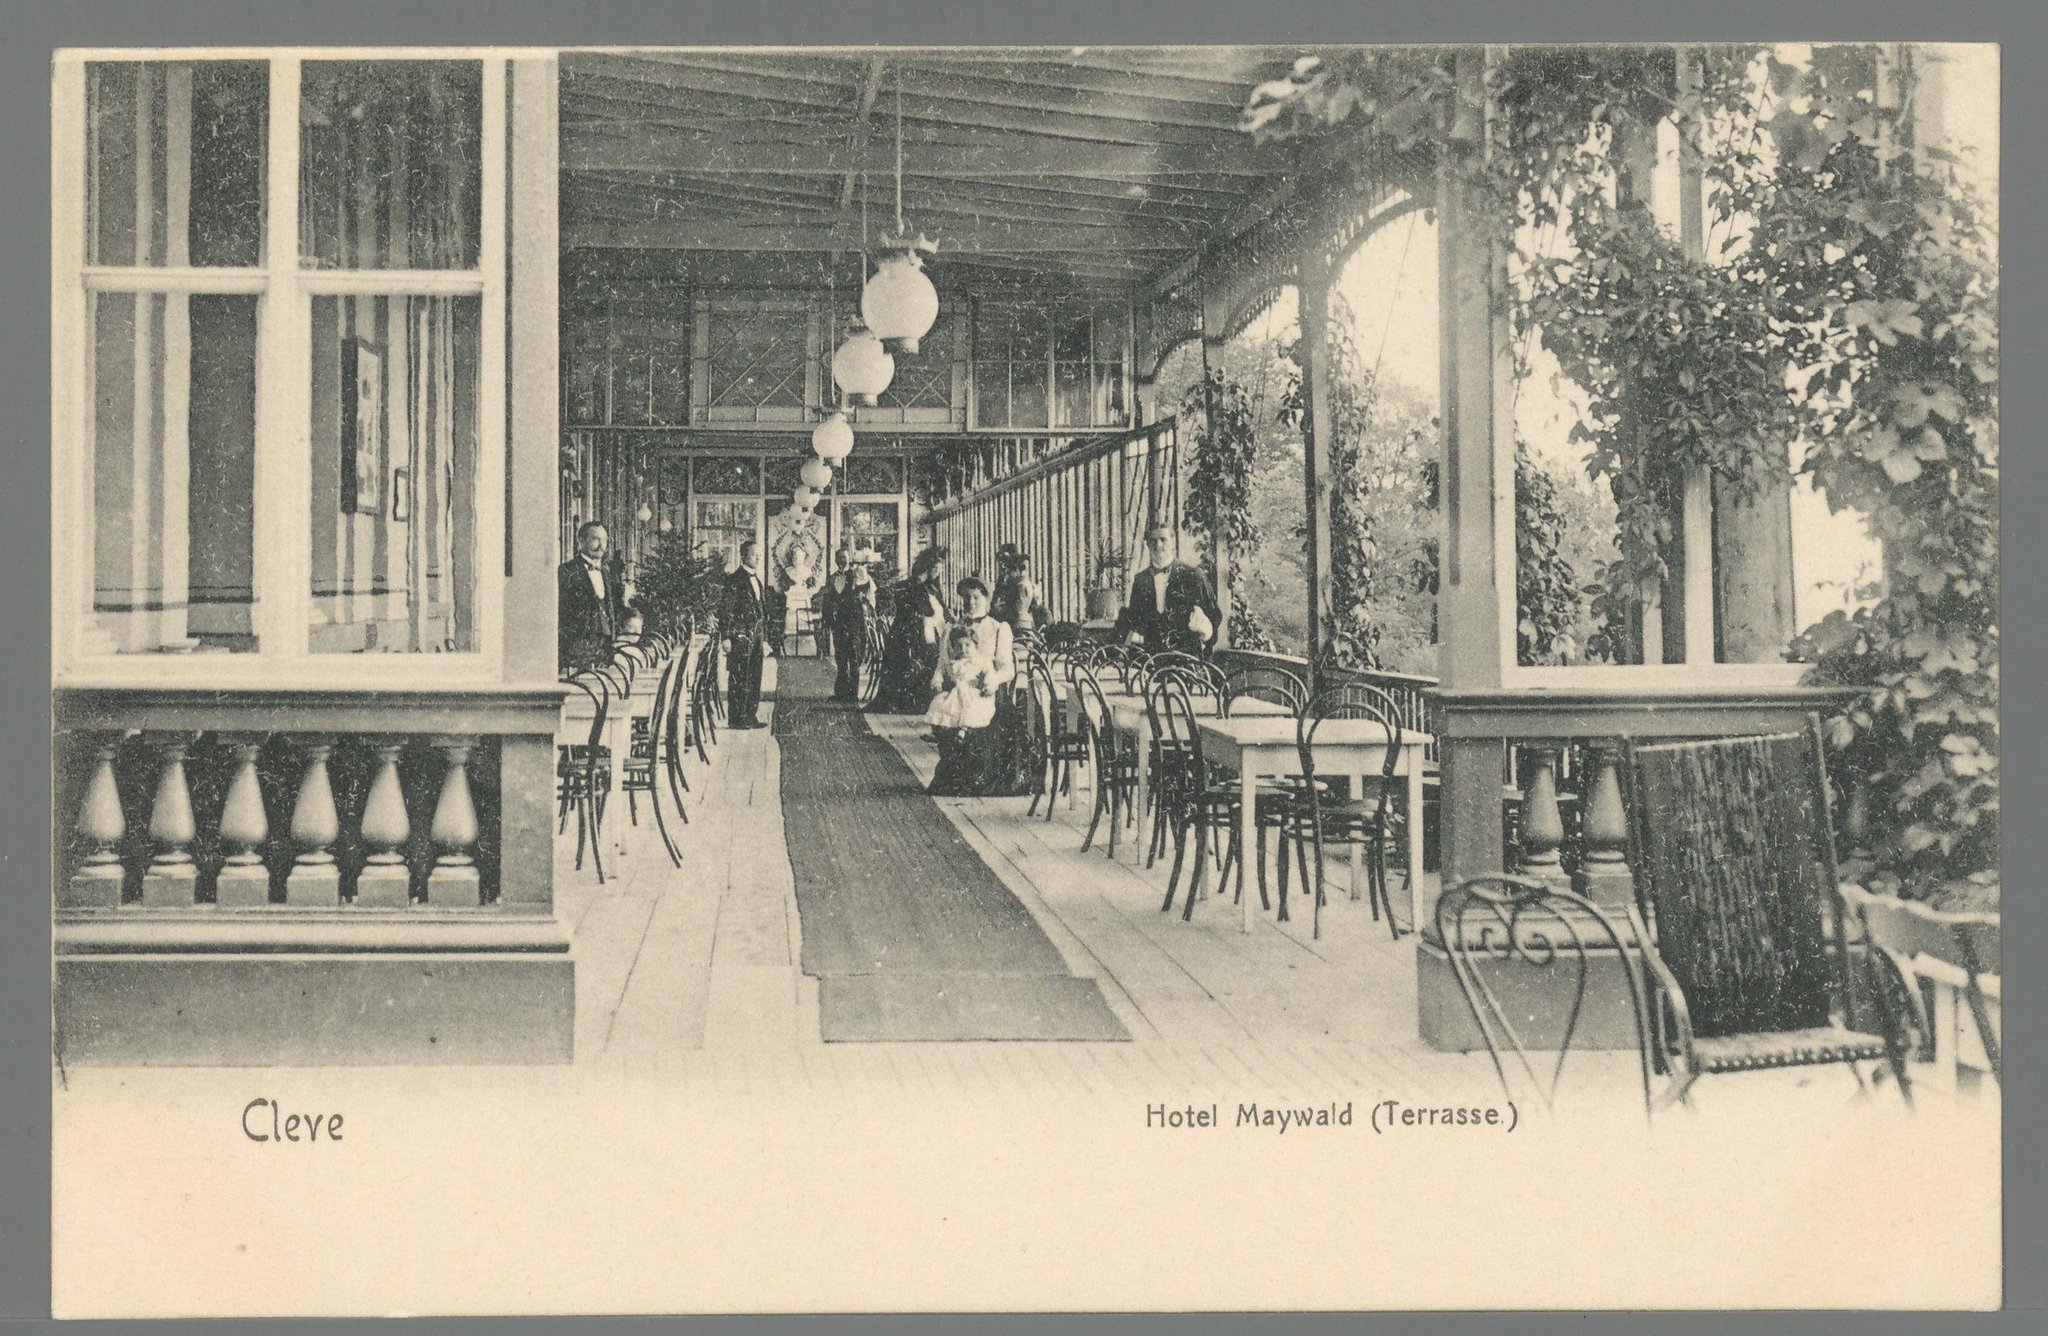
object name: ansichtkaart, prentbriefkaart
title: Cleve. Hôtel Maywald (Terrasse)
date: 1885-1905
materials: cardboard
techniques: photograph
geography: cleves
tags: hotel, hostelry, inn, cleves